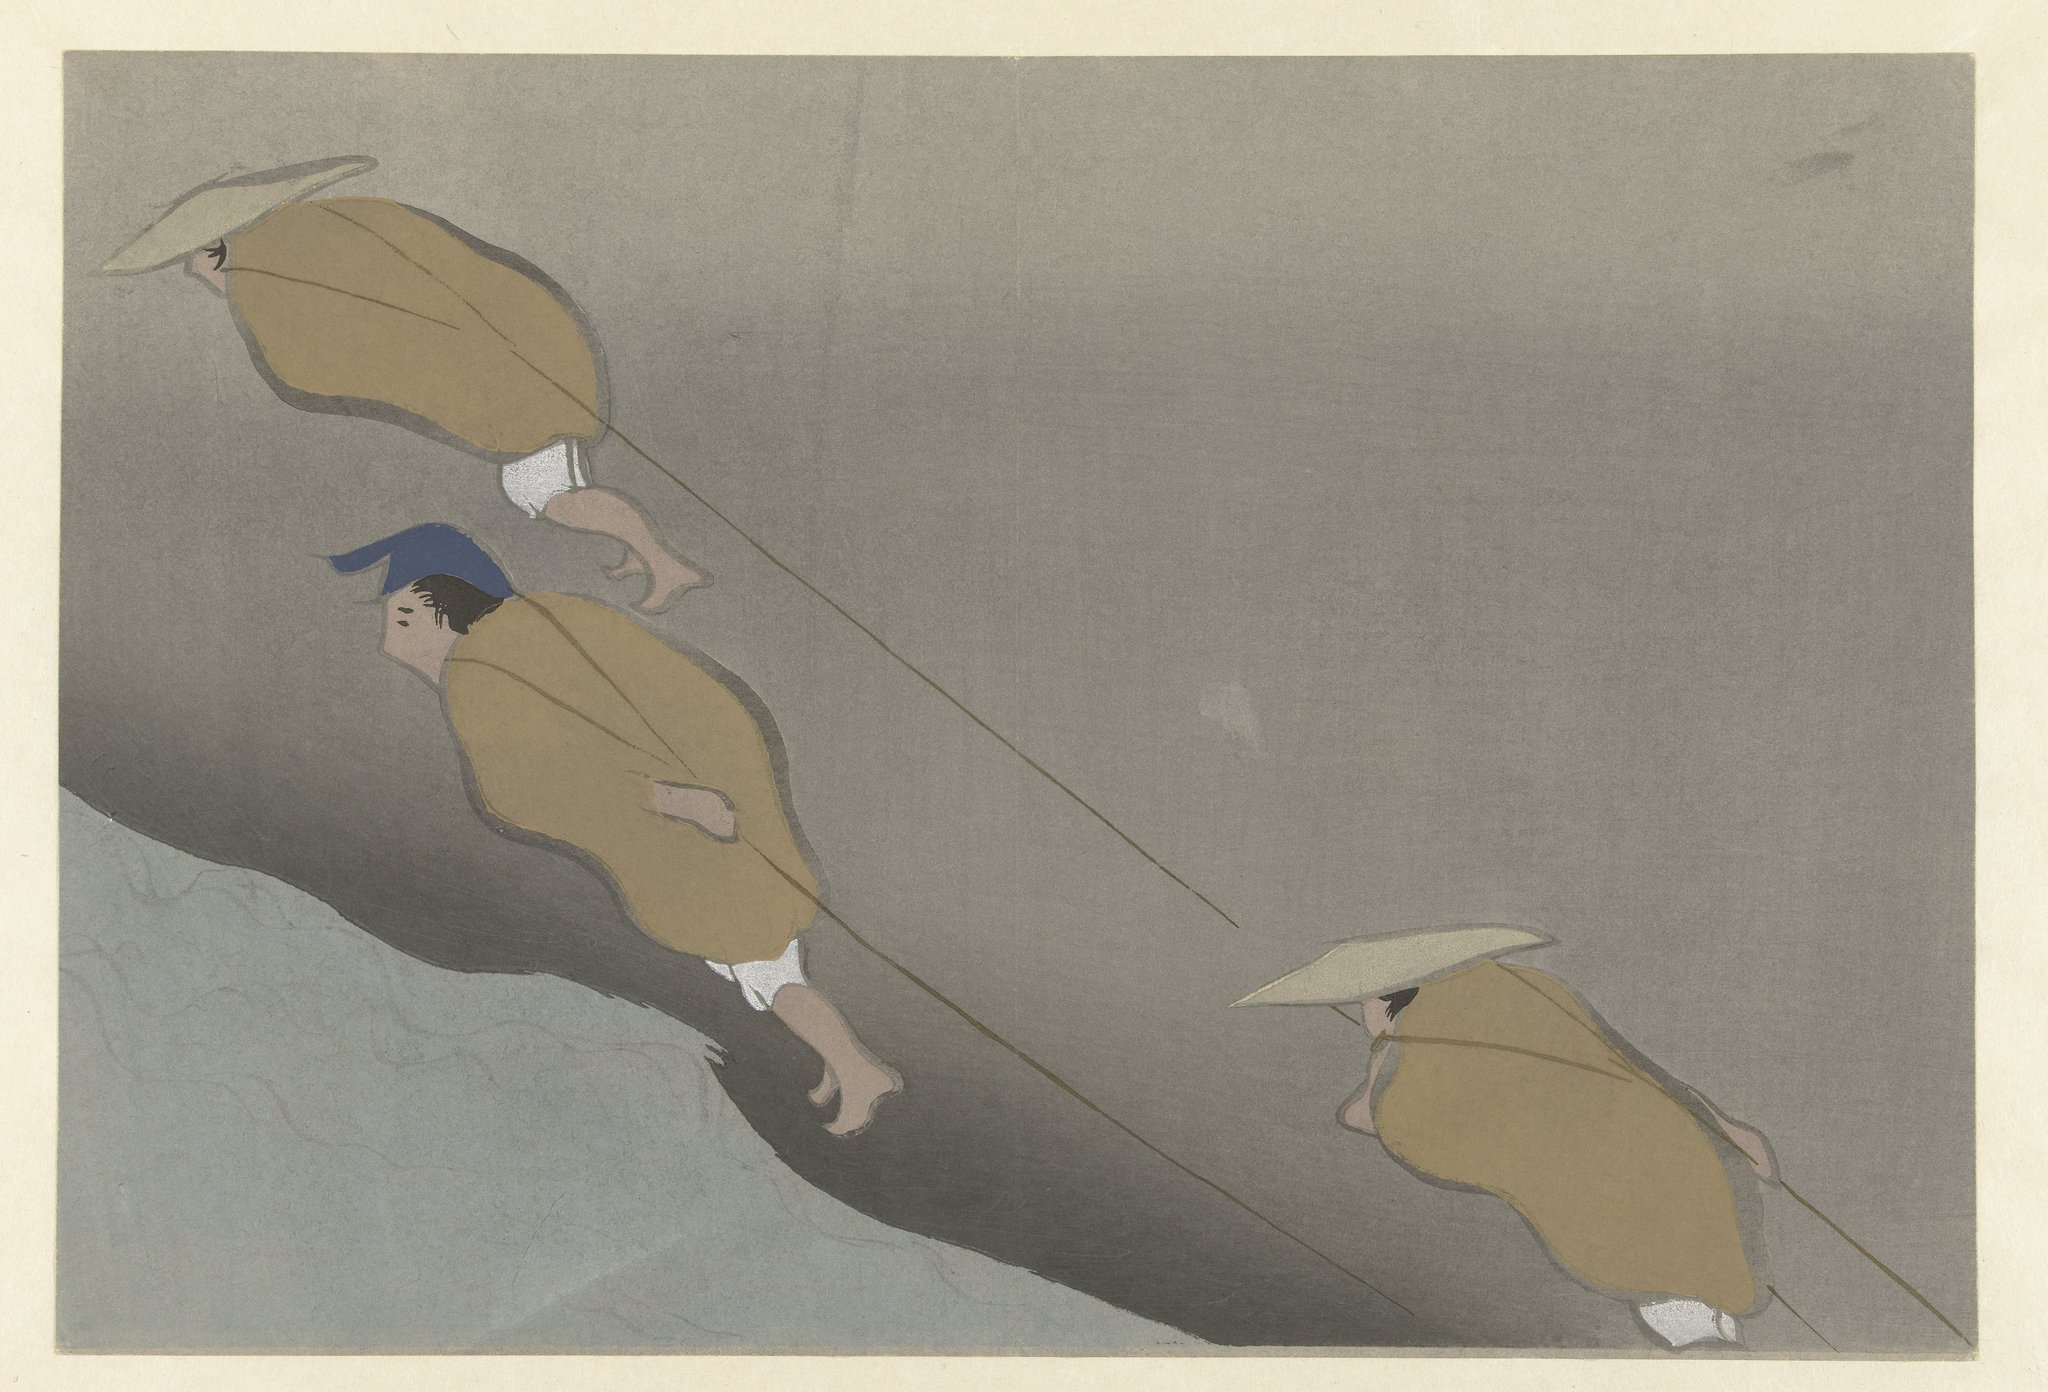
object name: print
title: Momoyogusa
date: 1909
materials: paper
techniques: woodcut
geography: kyoto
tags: drawing, pulling something, adult man (+ three persons)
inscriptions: collector's mark: Lugt 2760, collector's mark: Lugt 2228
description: Drie mannen, voorovergebogen, op bloten voeten, langs water lopend; de boot die ze voorttrekken is niet afgebeeld.